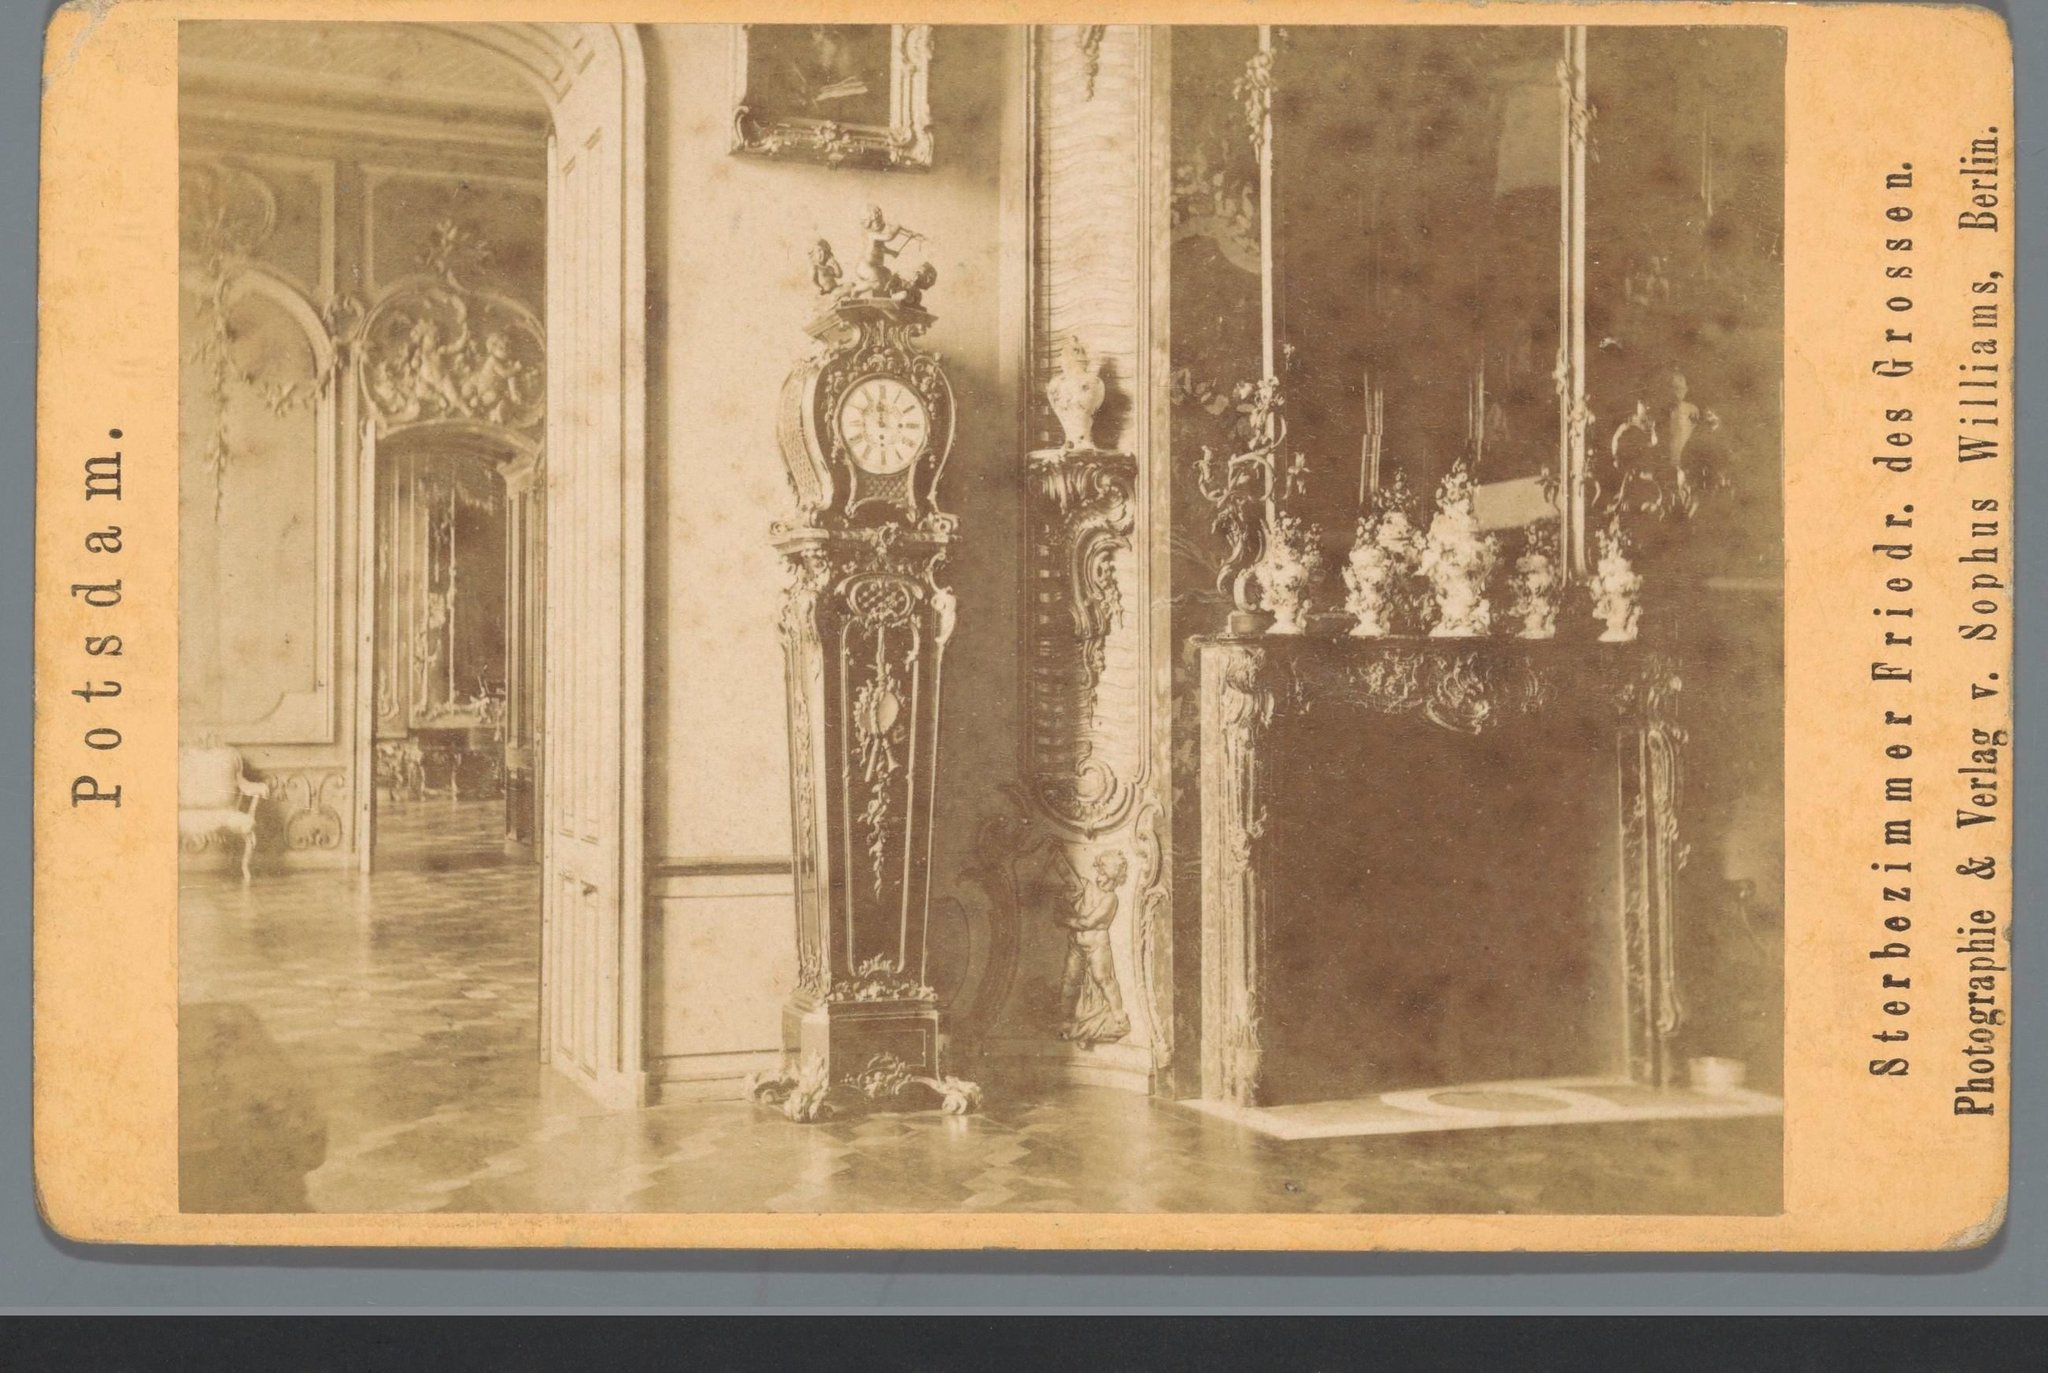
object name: carte de visite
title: Sterfkamer van Frederik de Grote in slot Sanssouci, Potsdam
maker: sophus williams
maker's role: publisher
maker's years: 1835-1900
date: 1855-1885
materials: cardboard, paper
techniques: albumen print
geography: berlin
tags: palace - aa - civic architecture: inside